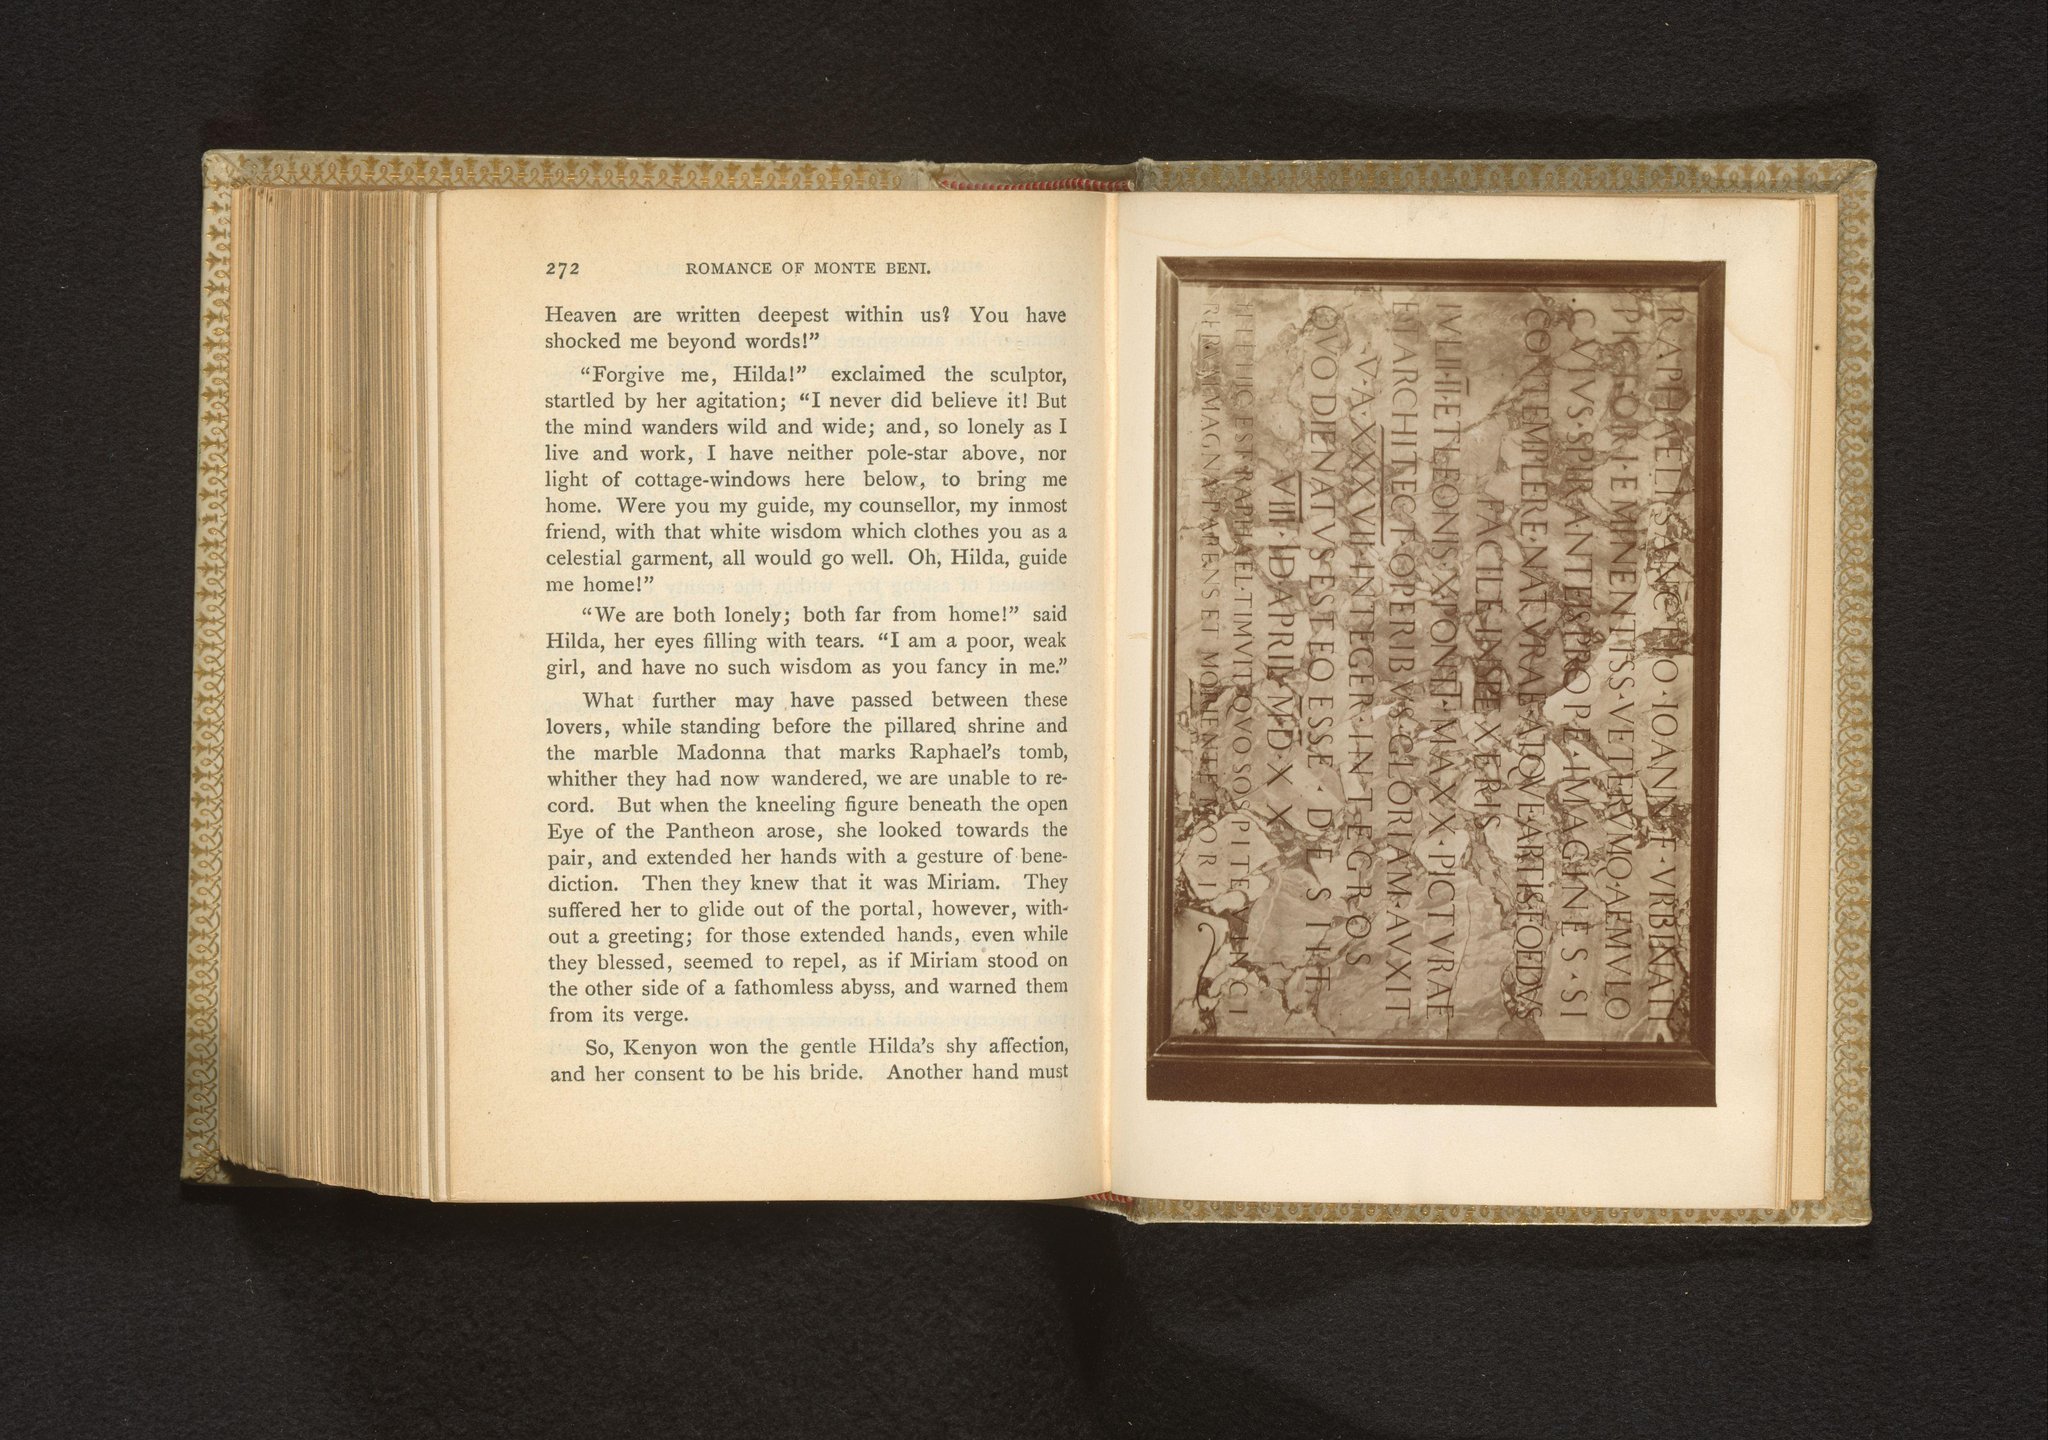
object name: photograph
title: Inscriptie op de tombe van Rafaël in het Pantheon in Rome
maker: Anonymous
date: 1850-1860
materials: photographic support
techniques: albumen print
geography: pantheon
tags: grave, tomb